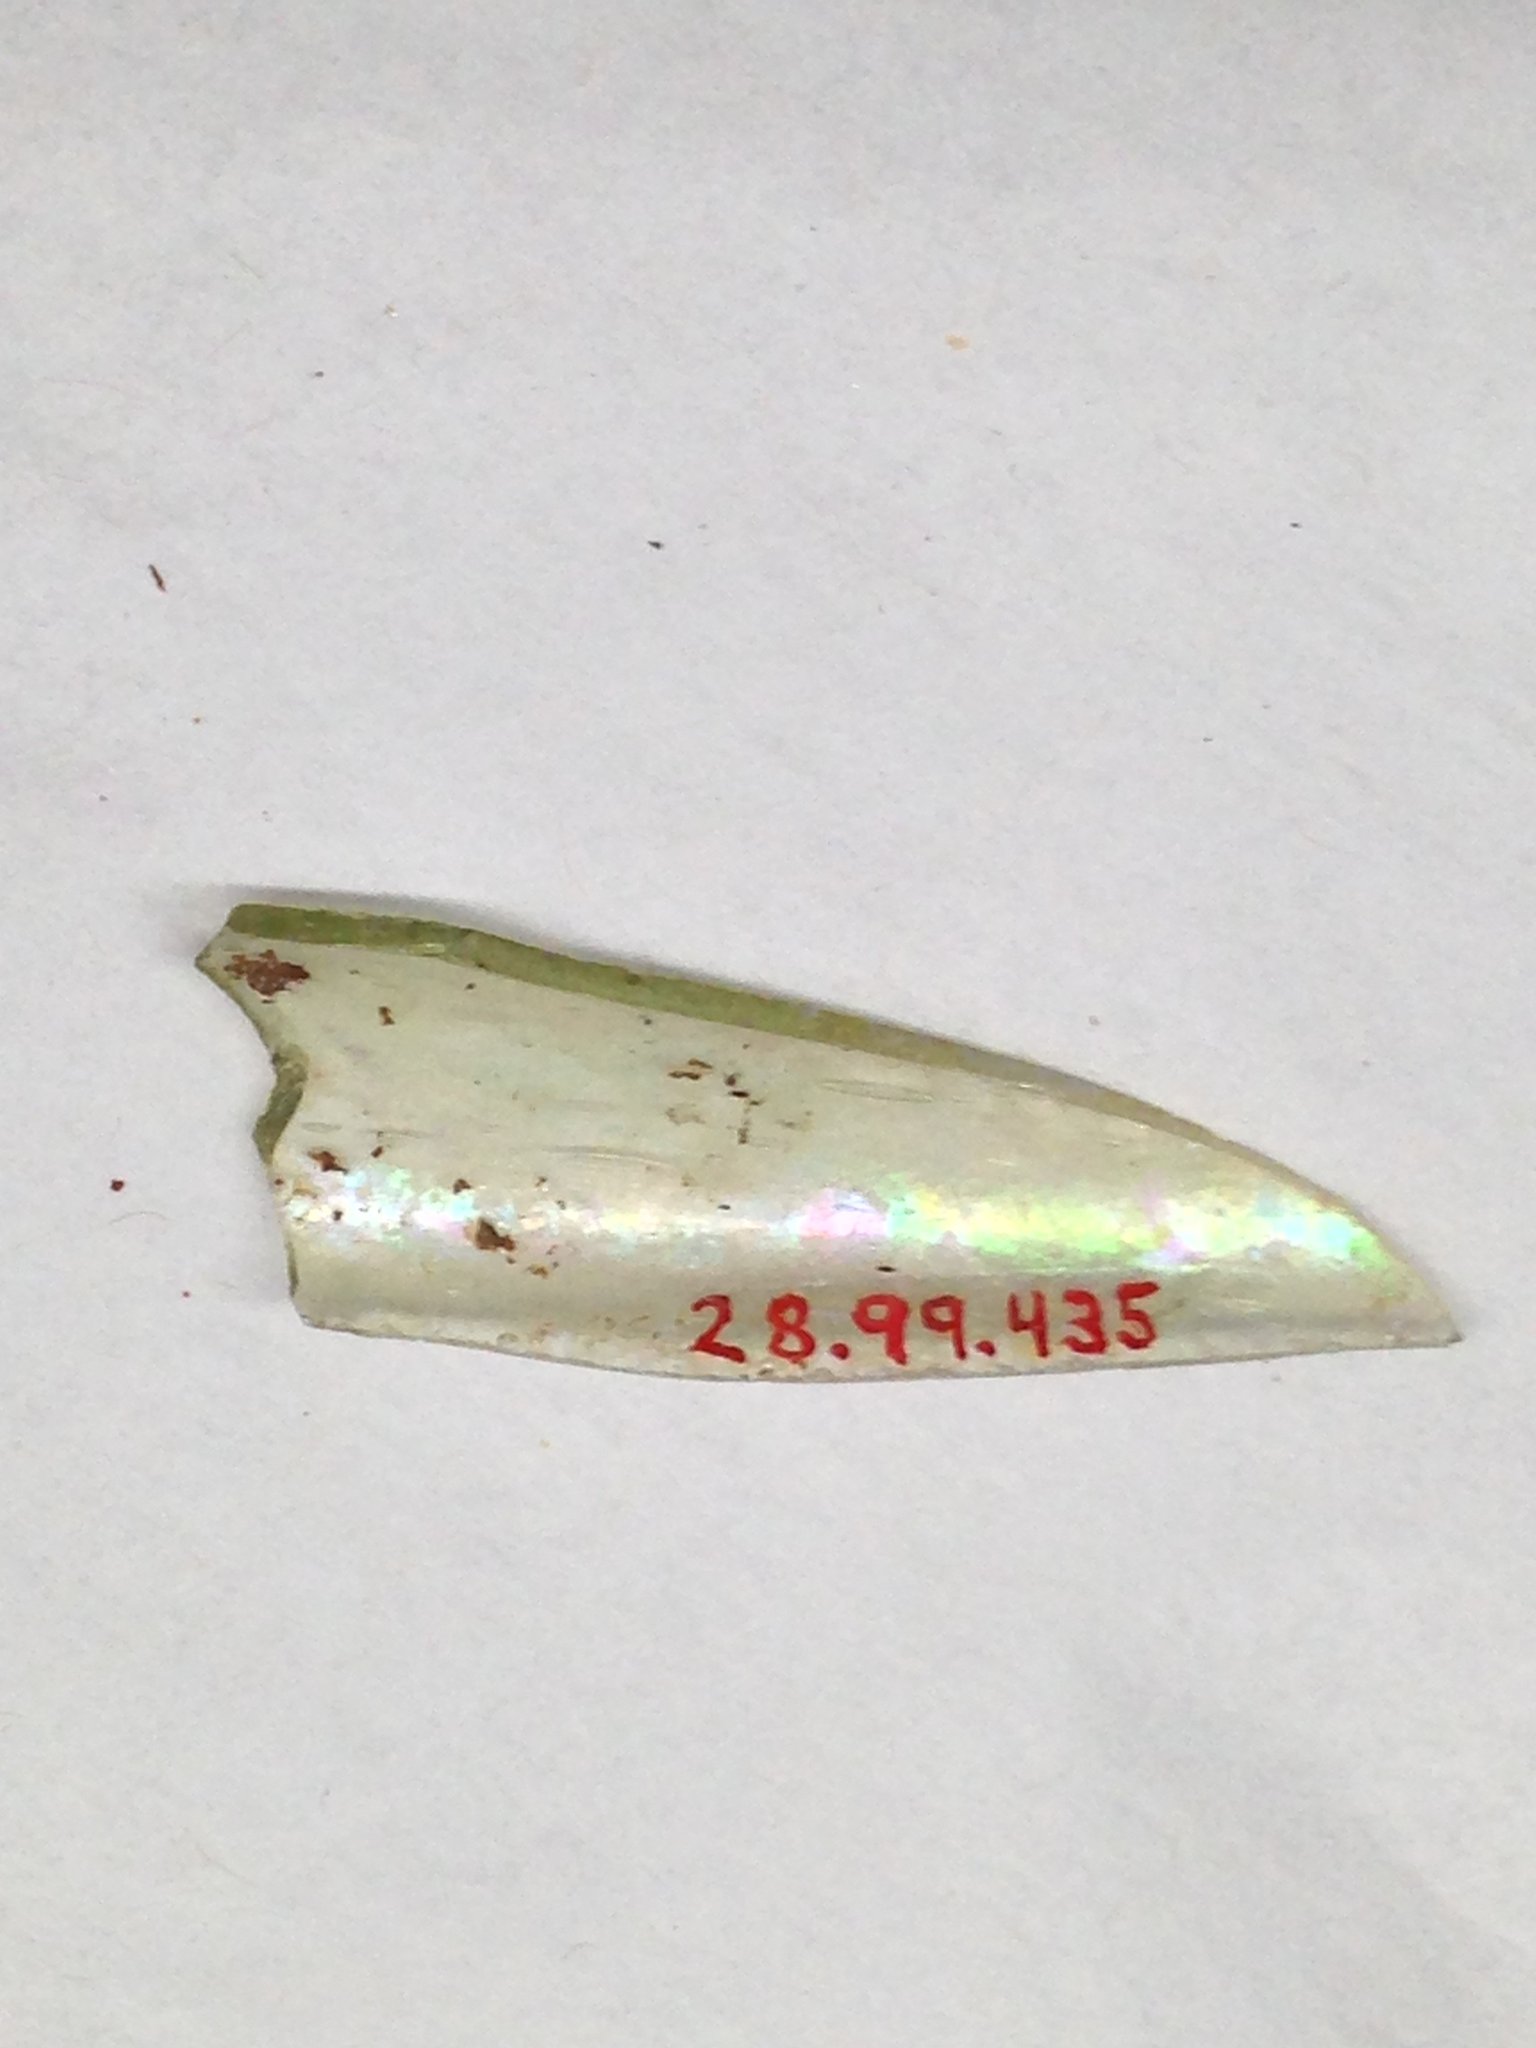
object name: fragment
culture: european or middle eastern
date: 1150-1250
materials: ceramic, glass